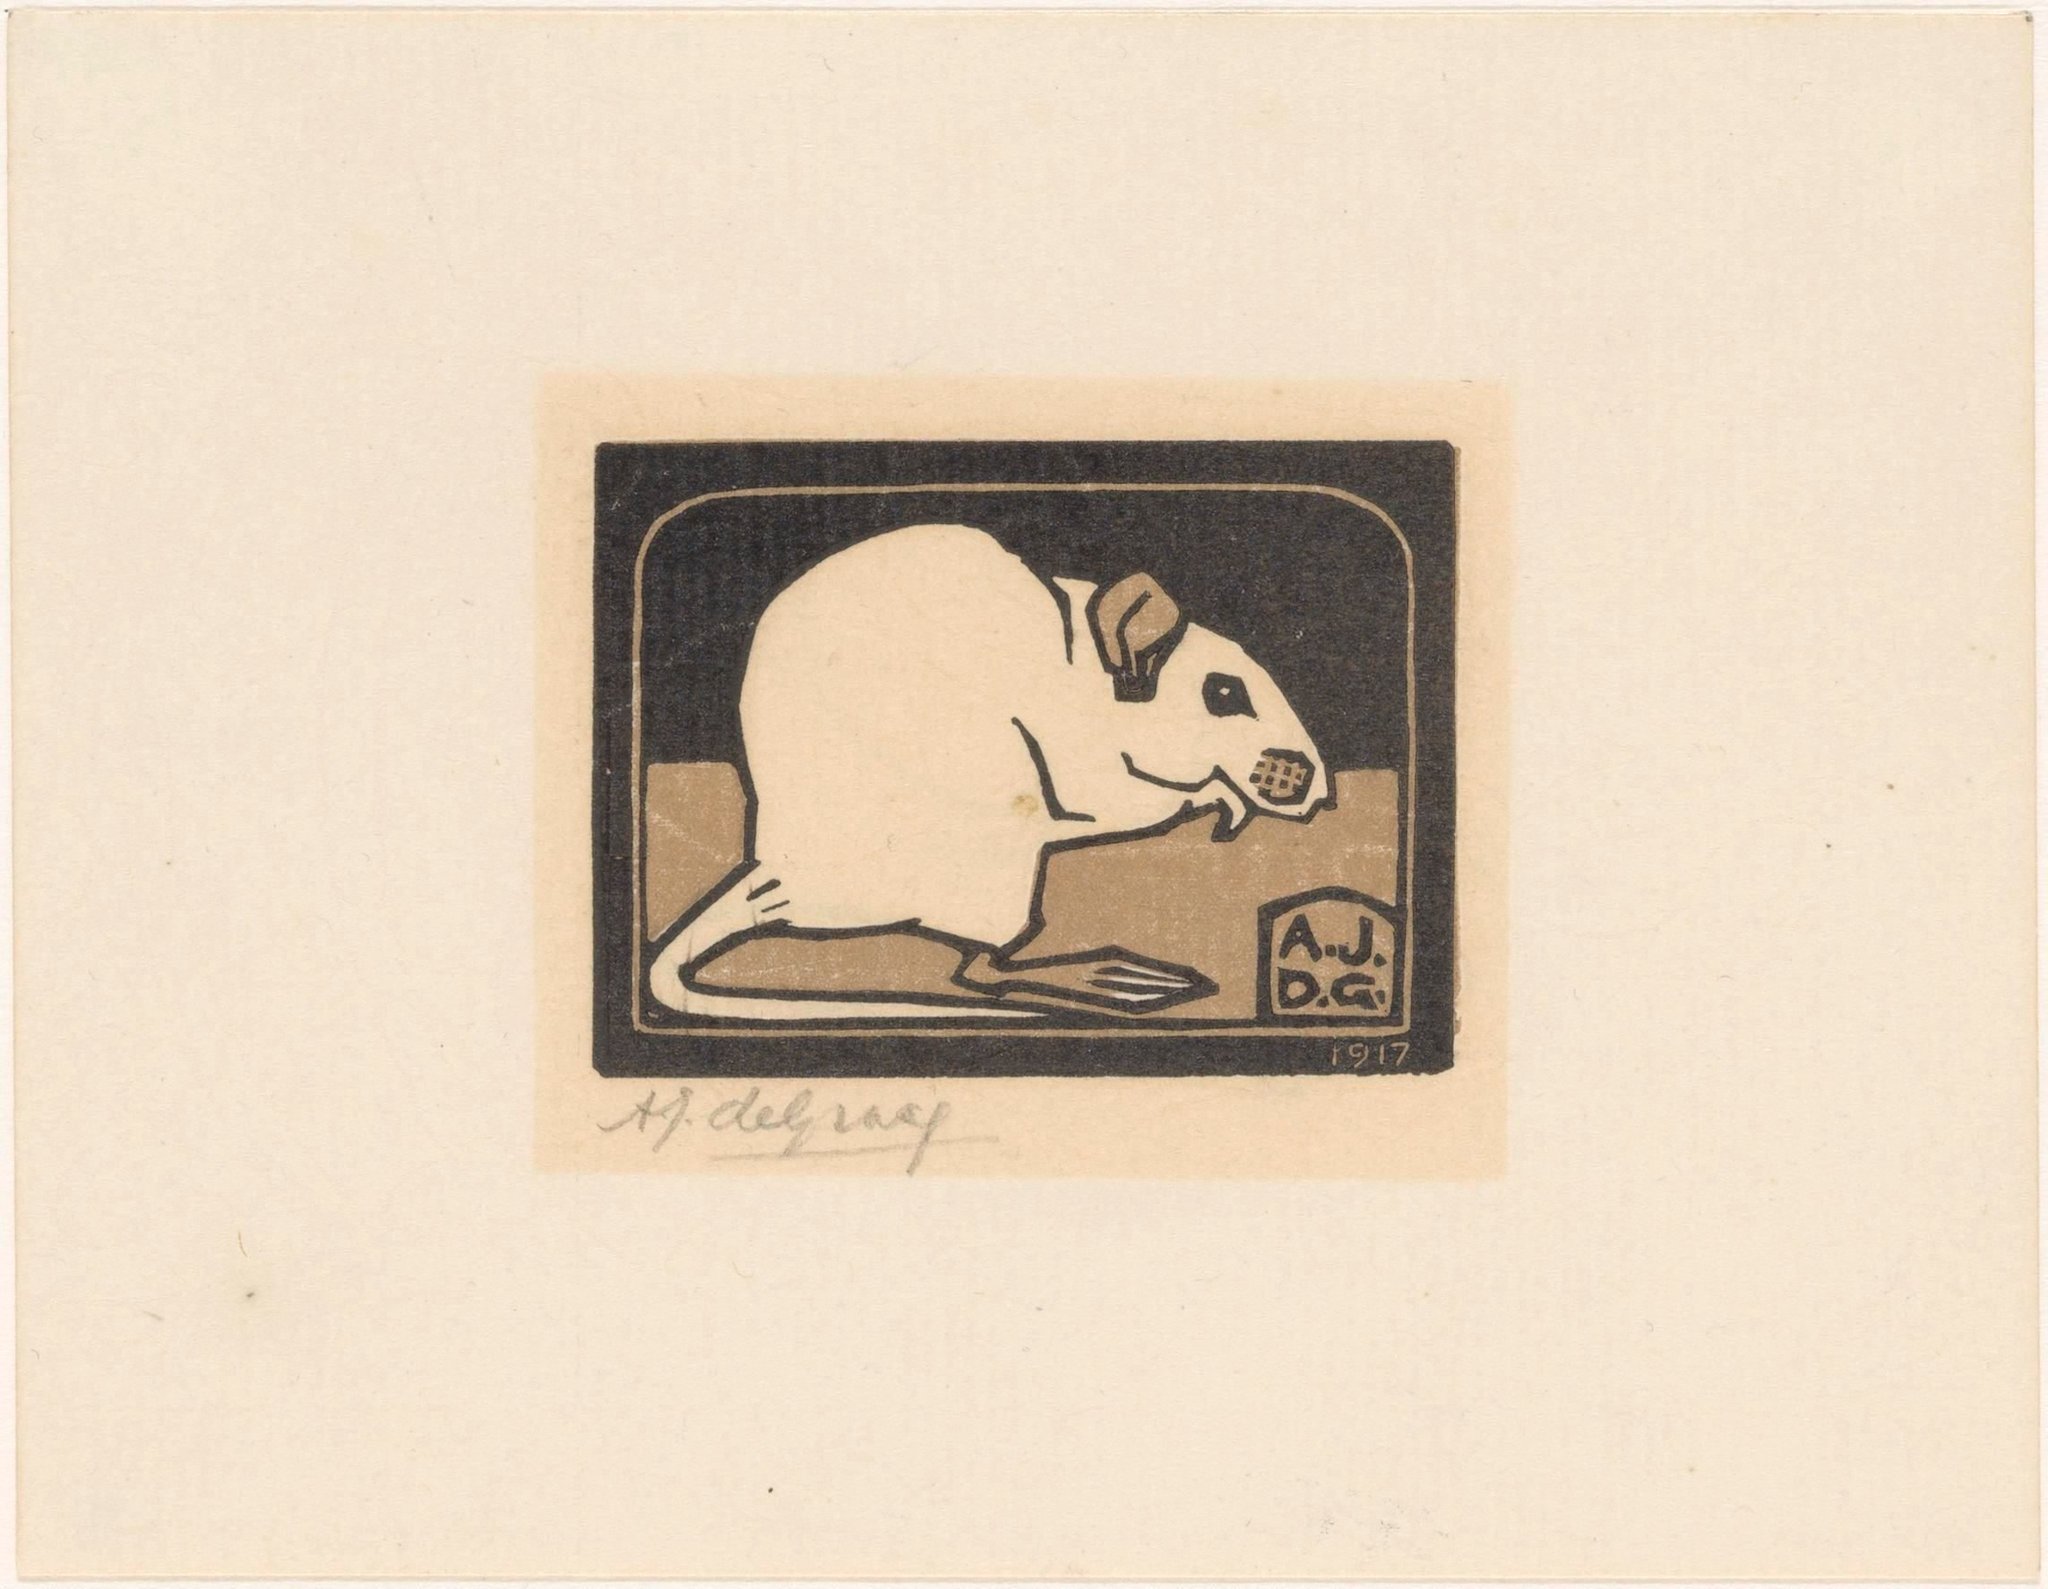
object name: print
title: Zittende muis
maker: julie de graag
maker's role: draughtsman, print maker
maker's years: 1877-1924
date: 1917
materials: paper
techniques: woodcut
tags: rodents: mouse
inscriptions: collector's mark: Lugt 2228